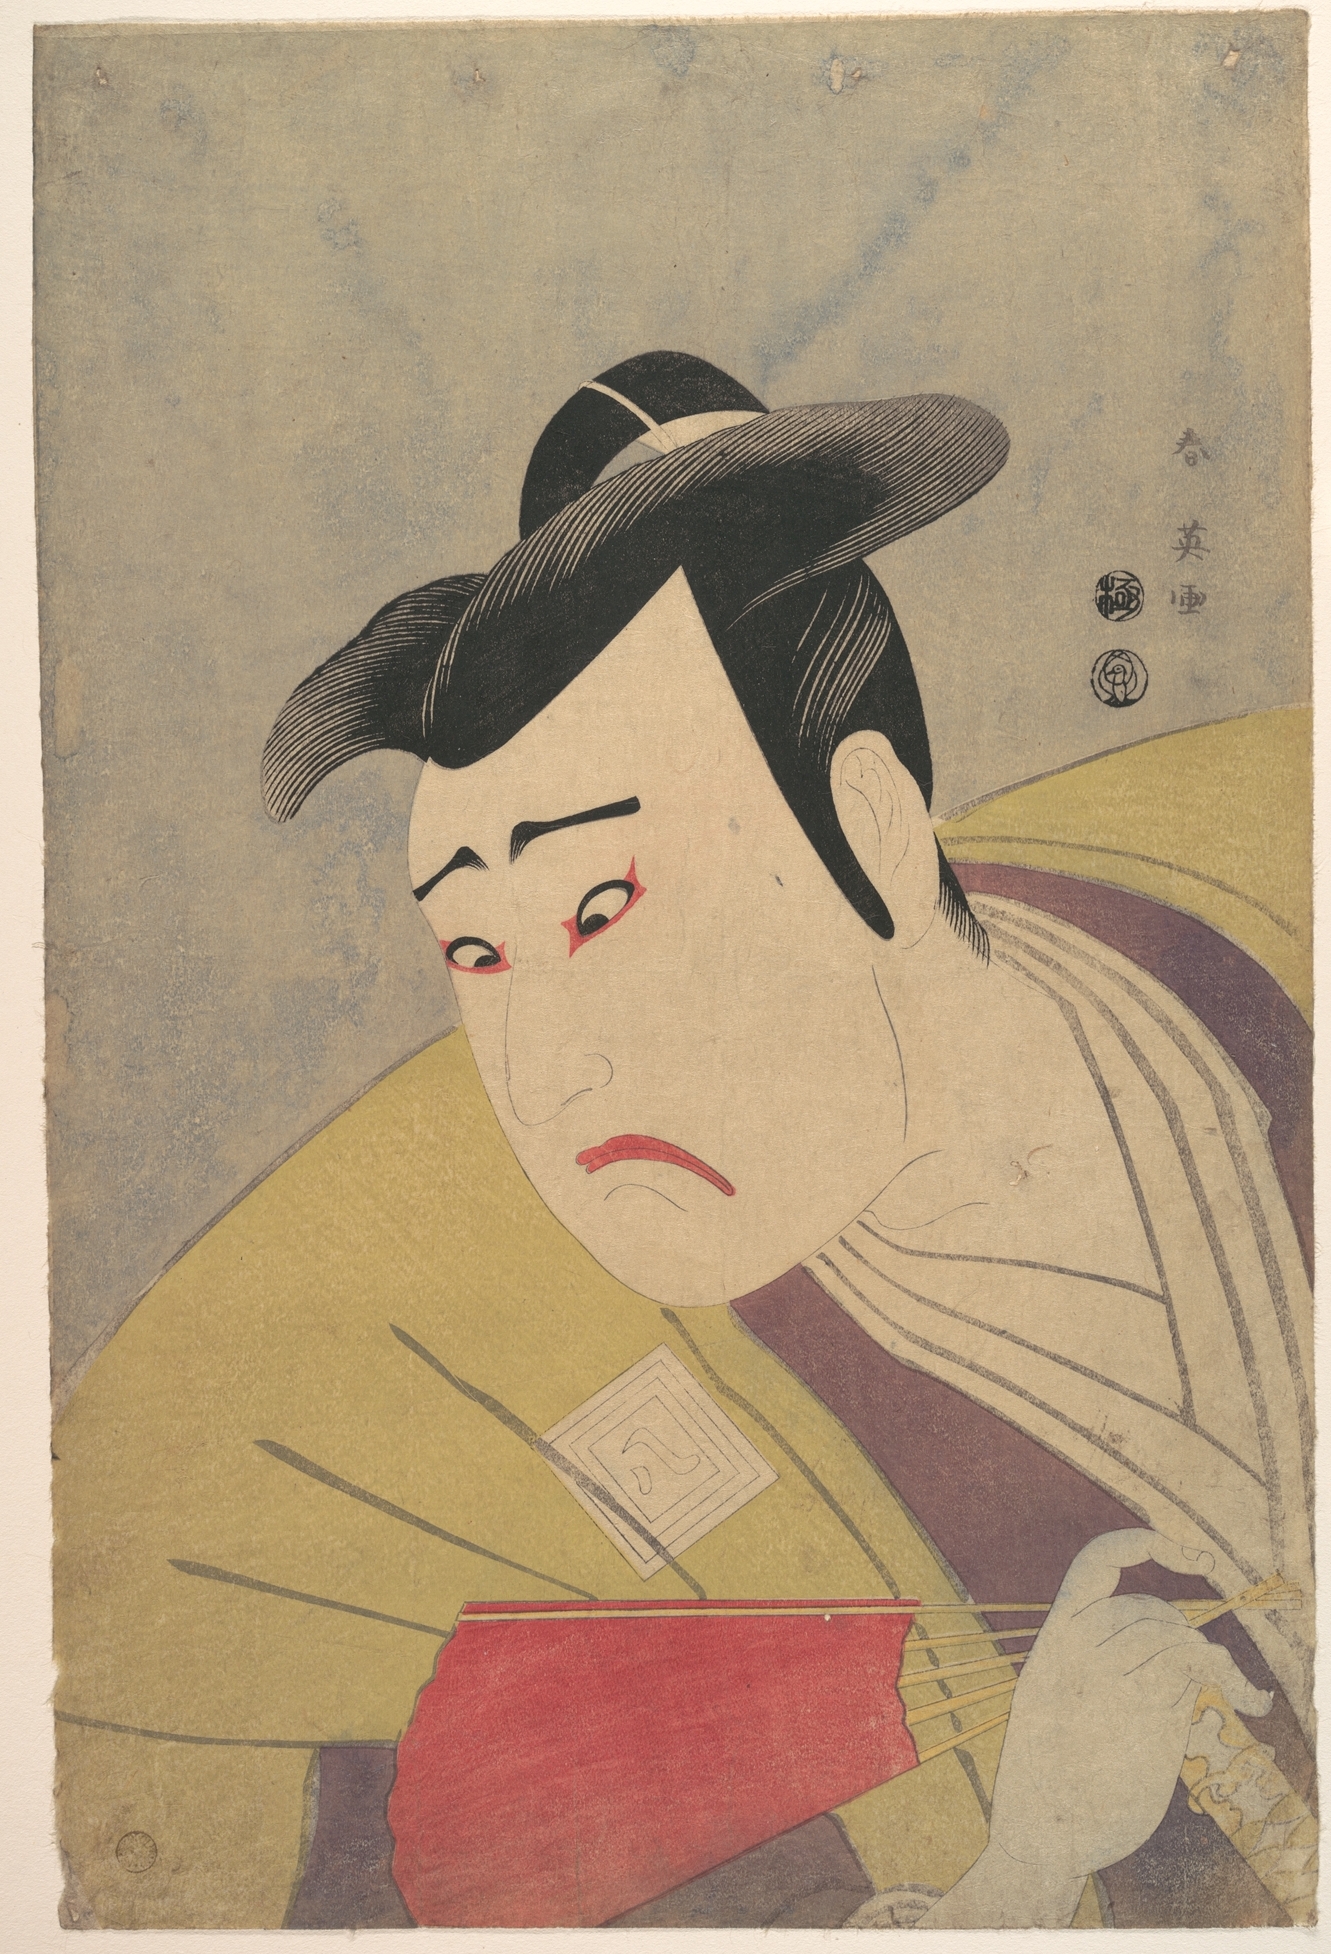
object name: print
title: The Actor Ichikawa Yaozō III Holding a Red Fan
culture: japanese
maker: katsukawa shun'ei 勝川春英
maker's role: artist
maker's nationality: japanese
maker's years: 1762-1819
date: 1794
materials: ink, paper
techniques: woodblock print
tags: fans,men,portraits,actors